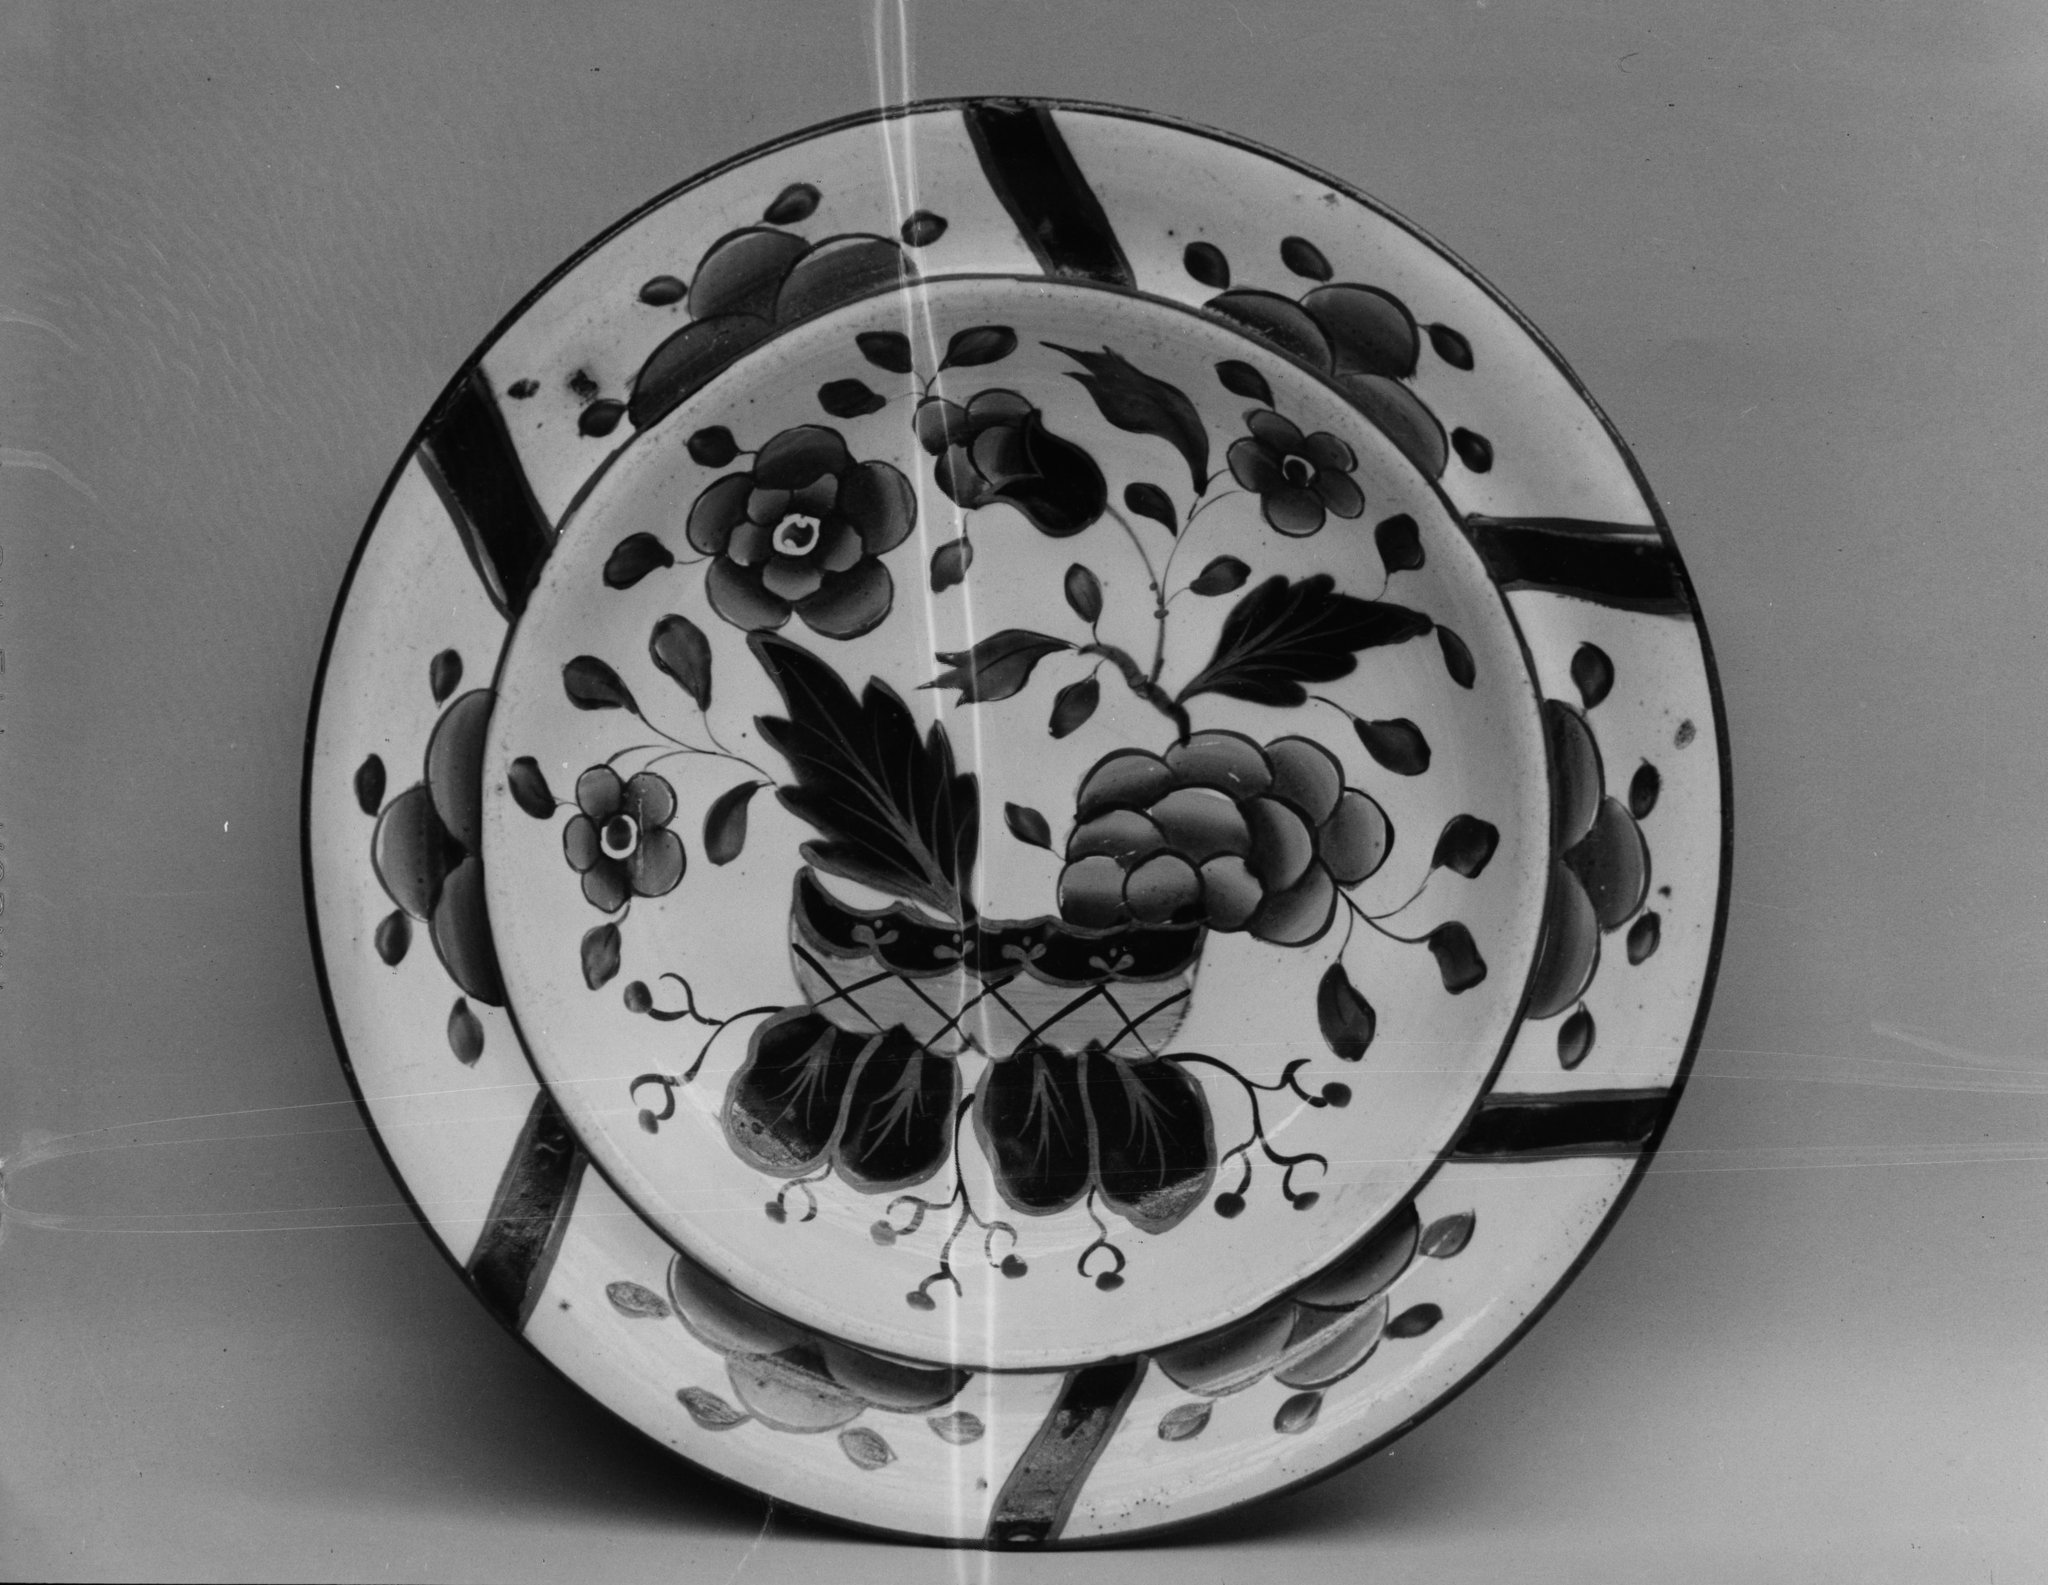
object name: dish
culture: british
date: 1825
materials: earthenware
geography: england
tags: flowers